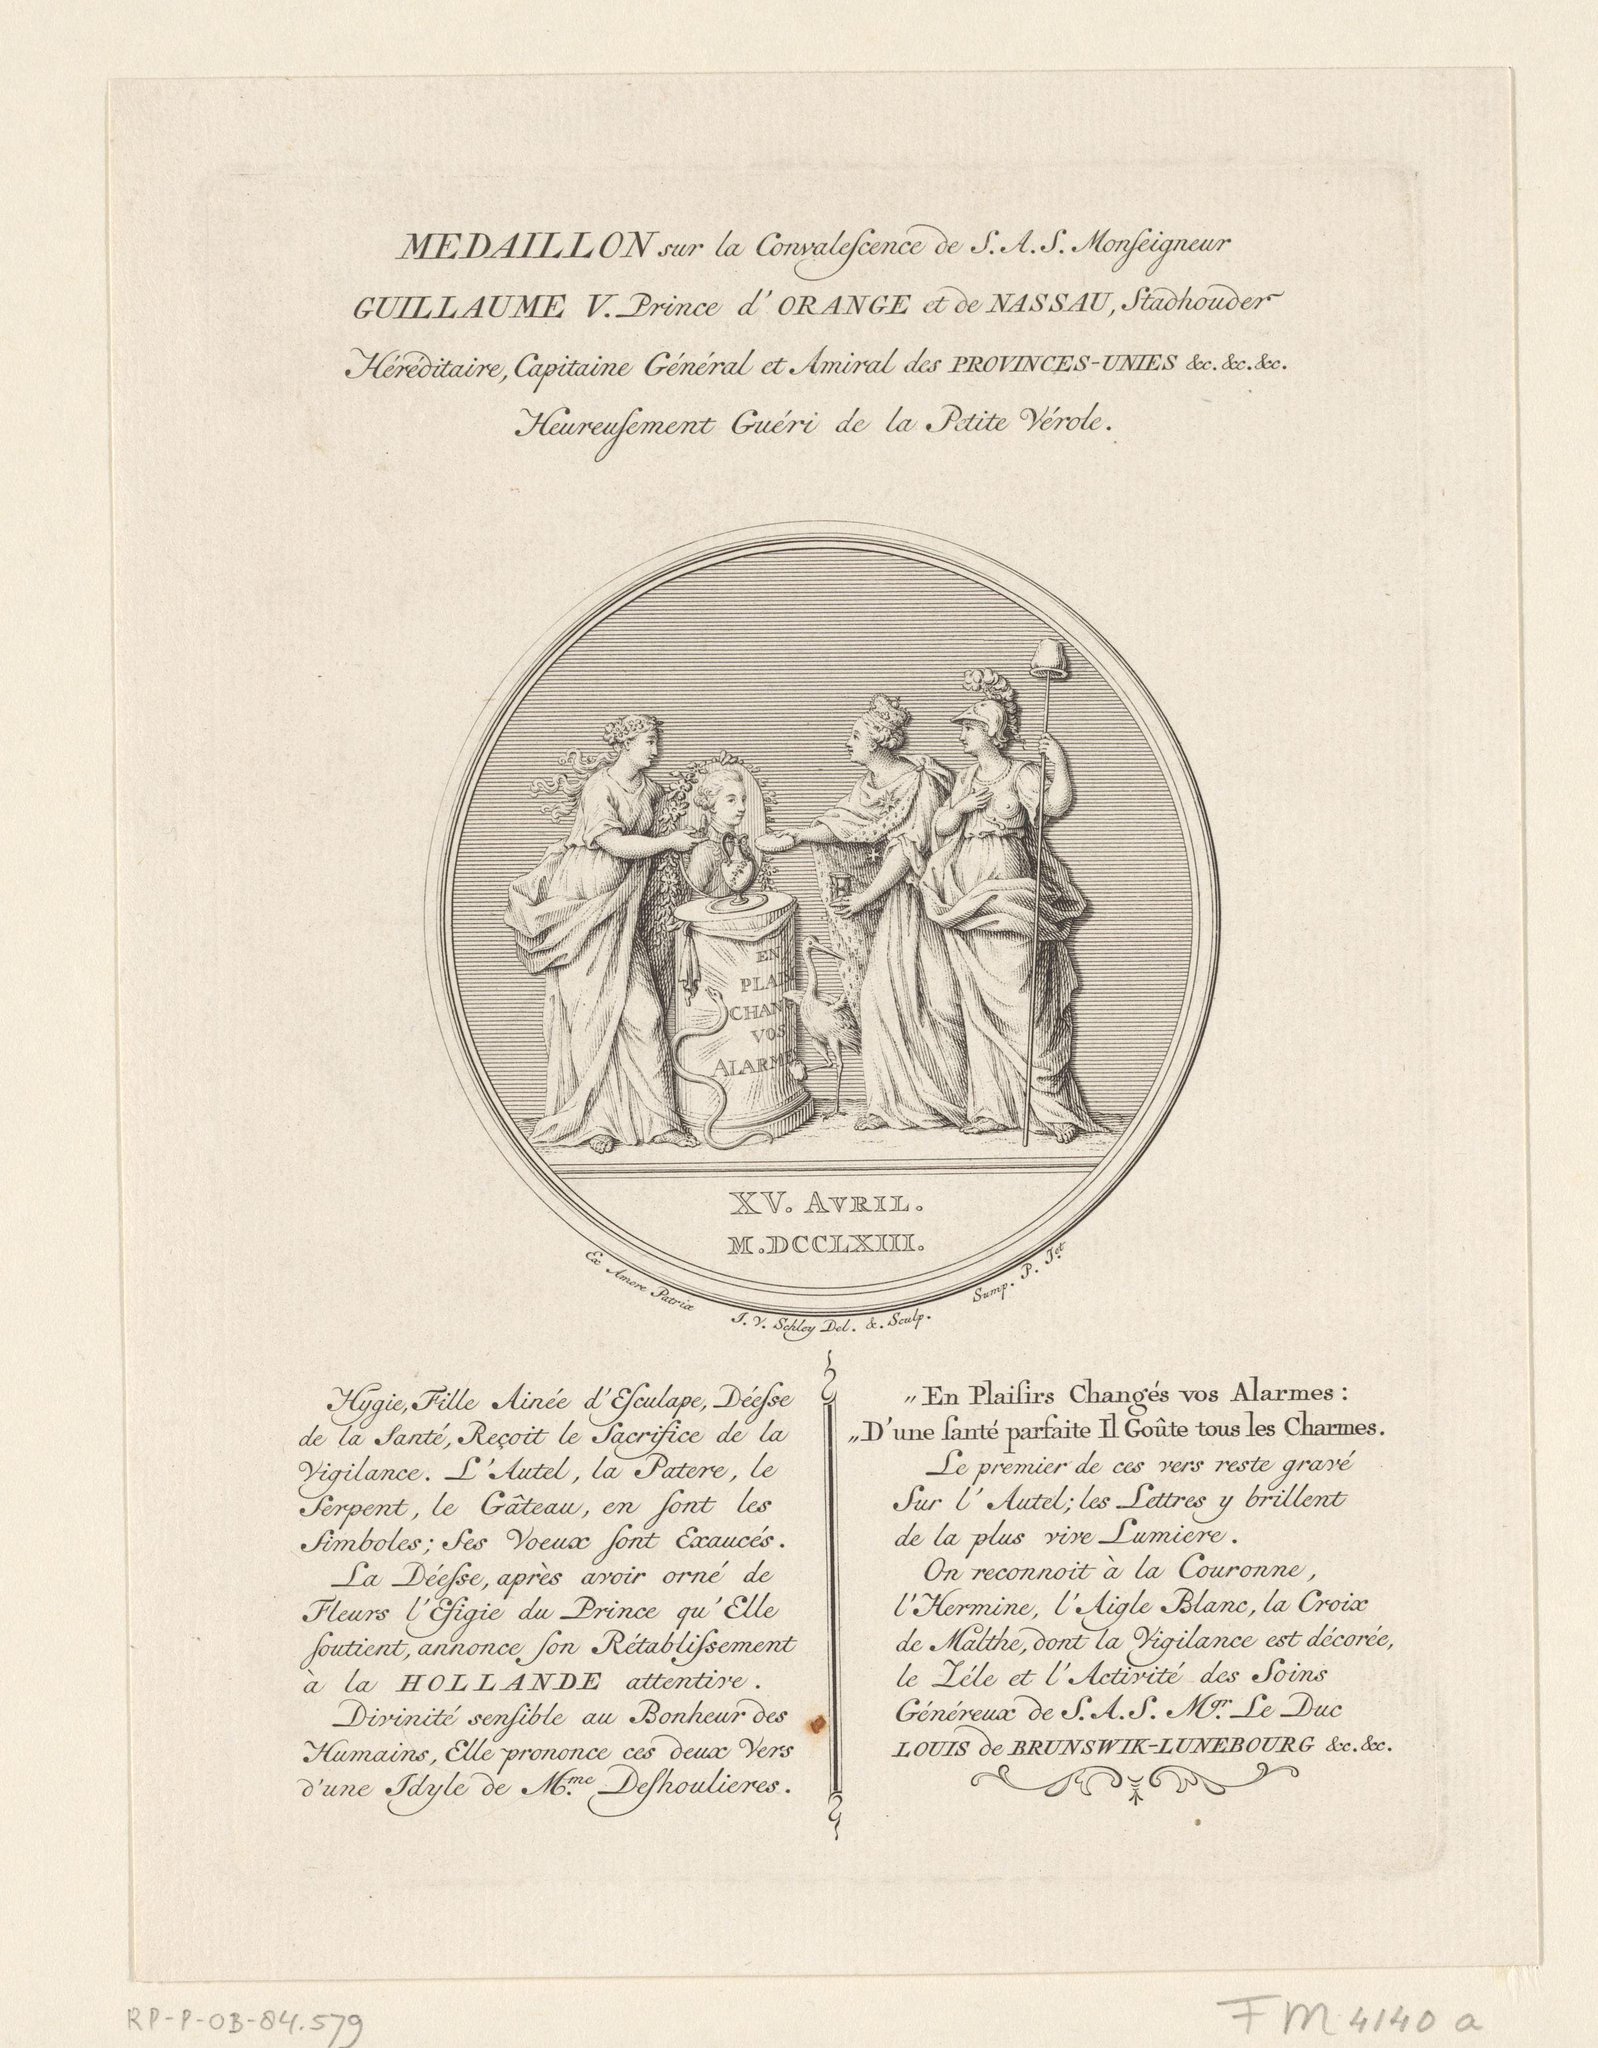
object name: print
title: Medaillon sur la Convalescence de S.A.S. Monseigneur Guillaume V. Prince d'Orange (...) Heureusement Guéri de la Petite Vérole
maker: jacob van der schley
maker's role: draughtsman, print maker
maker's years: 1715-1779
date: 1763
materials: paper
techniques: engraving, etching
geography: northern netherlands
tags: william v (prince of orange), personifications of countries, nations, states, districts, etc., hygieia (daughter of aesculapius) (+ specific aspects, allegorical aspects), alertness, vigilance; 'guardia', 'vigilanza', 'vigilanza per difendersi & oppugnare altri' (ripa) (+ personification), netherlands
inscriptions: collector's mark: Lugt 2228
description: Allegorisch medaillon ter gelegenheid van het herstel van stadhouder Willem V na een korte ziekte, 15 april 1763. Waakzaamheid en de Hollandse Maagd bij een altaar waarop een portret van de prins smeken Hygieia de prins te genezen. Onder de voorstelling een onderschrift in twee kolommen in het Frans.